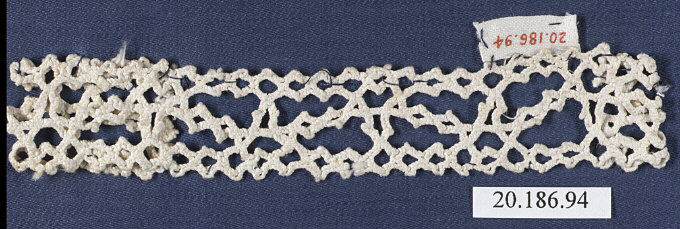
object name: insertion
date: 1501-1600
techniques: lace